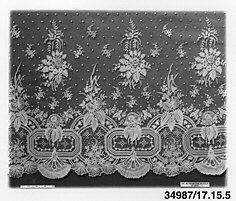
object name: flounce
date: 1860